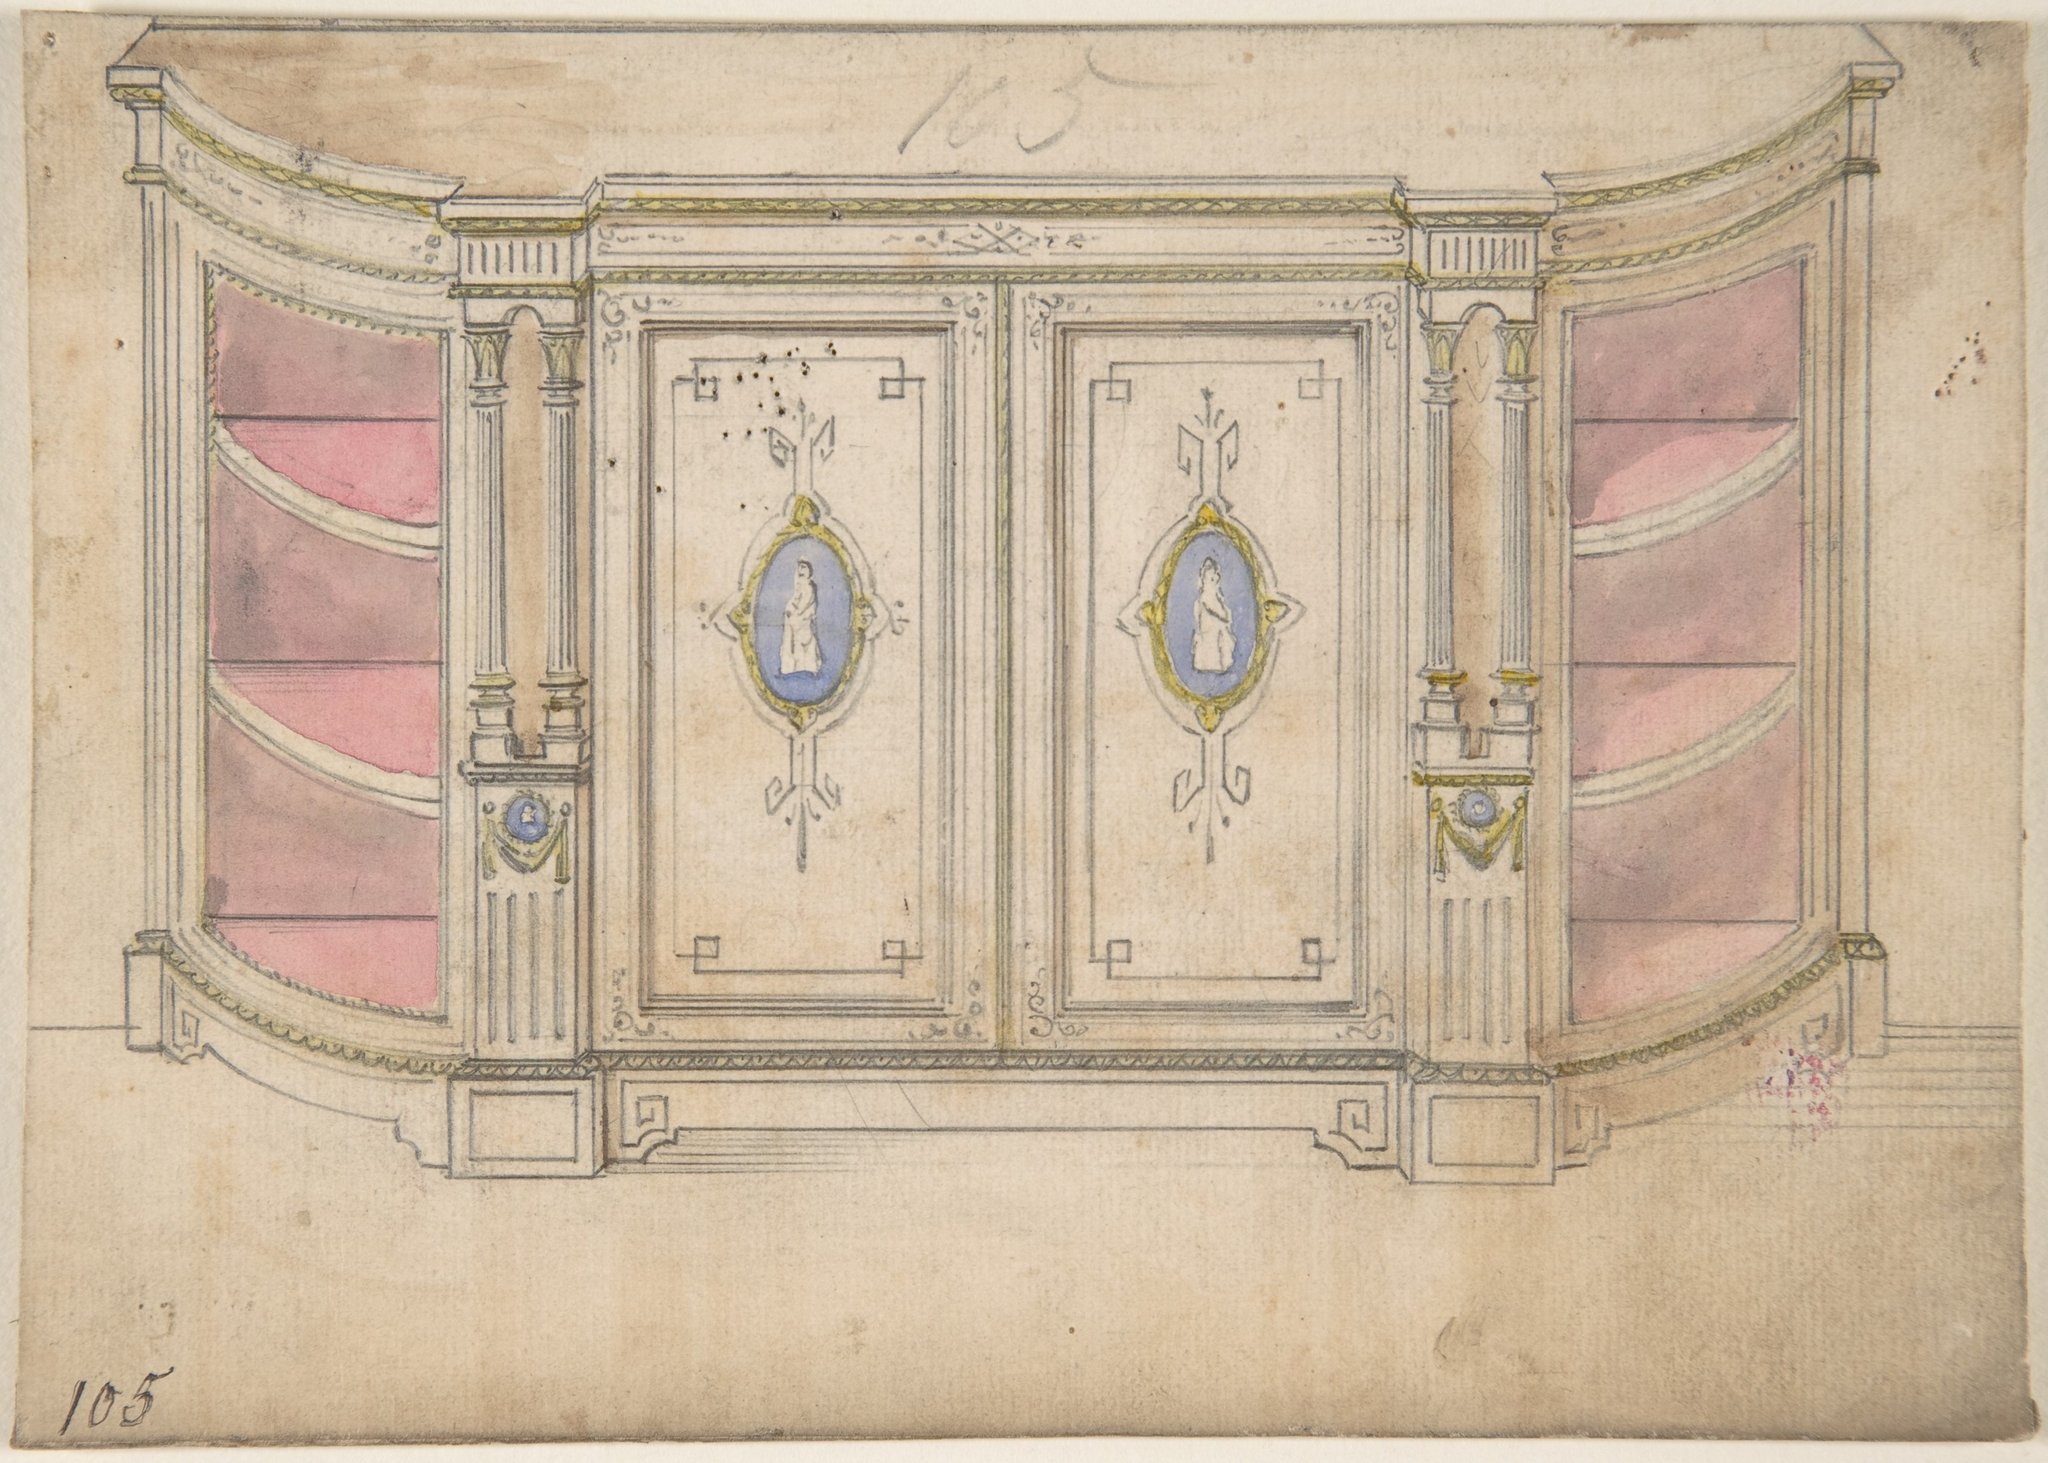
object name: drawing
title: Cabinet Design with Doors Adorned with Porcelain Plaques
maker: anonymous, british, 19th century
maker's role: artist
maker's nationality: british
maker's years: 1800-1900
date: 1801-1900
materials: ink, watercolor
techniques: pen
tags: cabinets